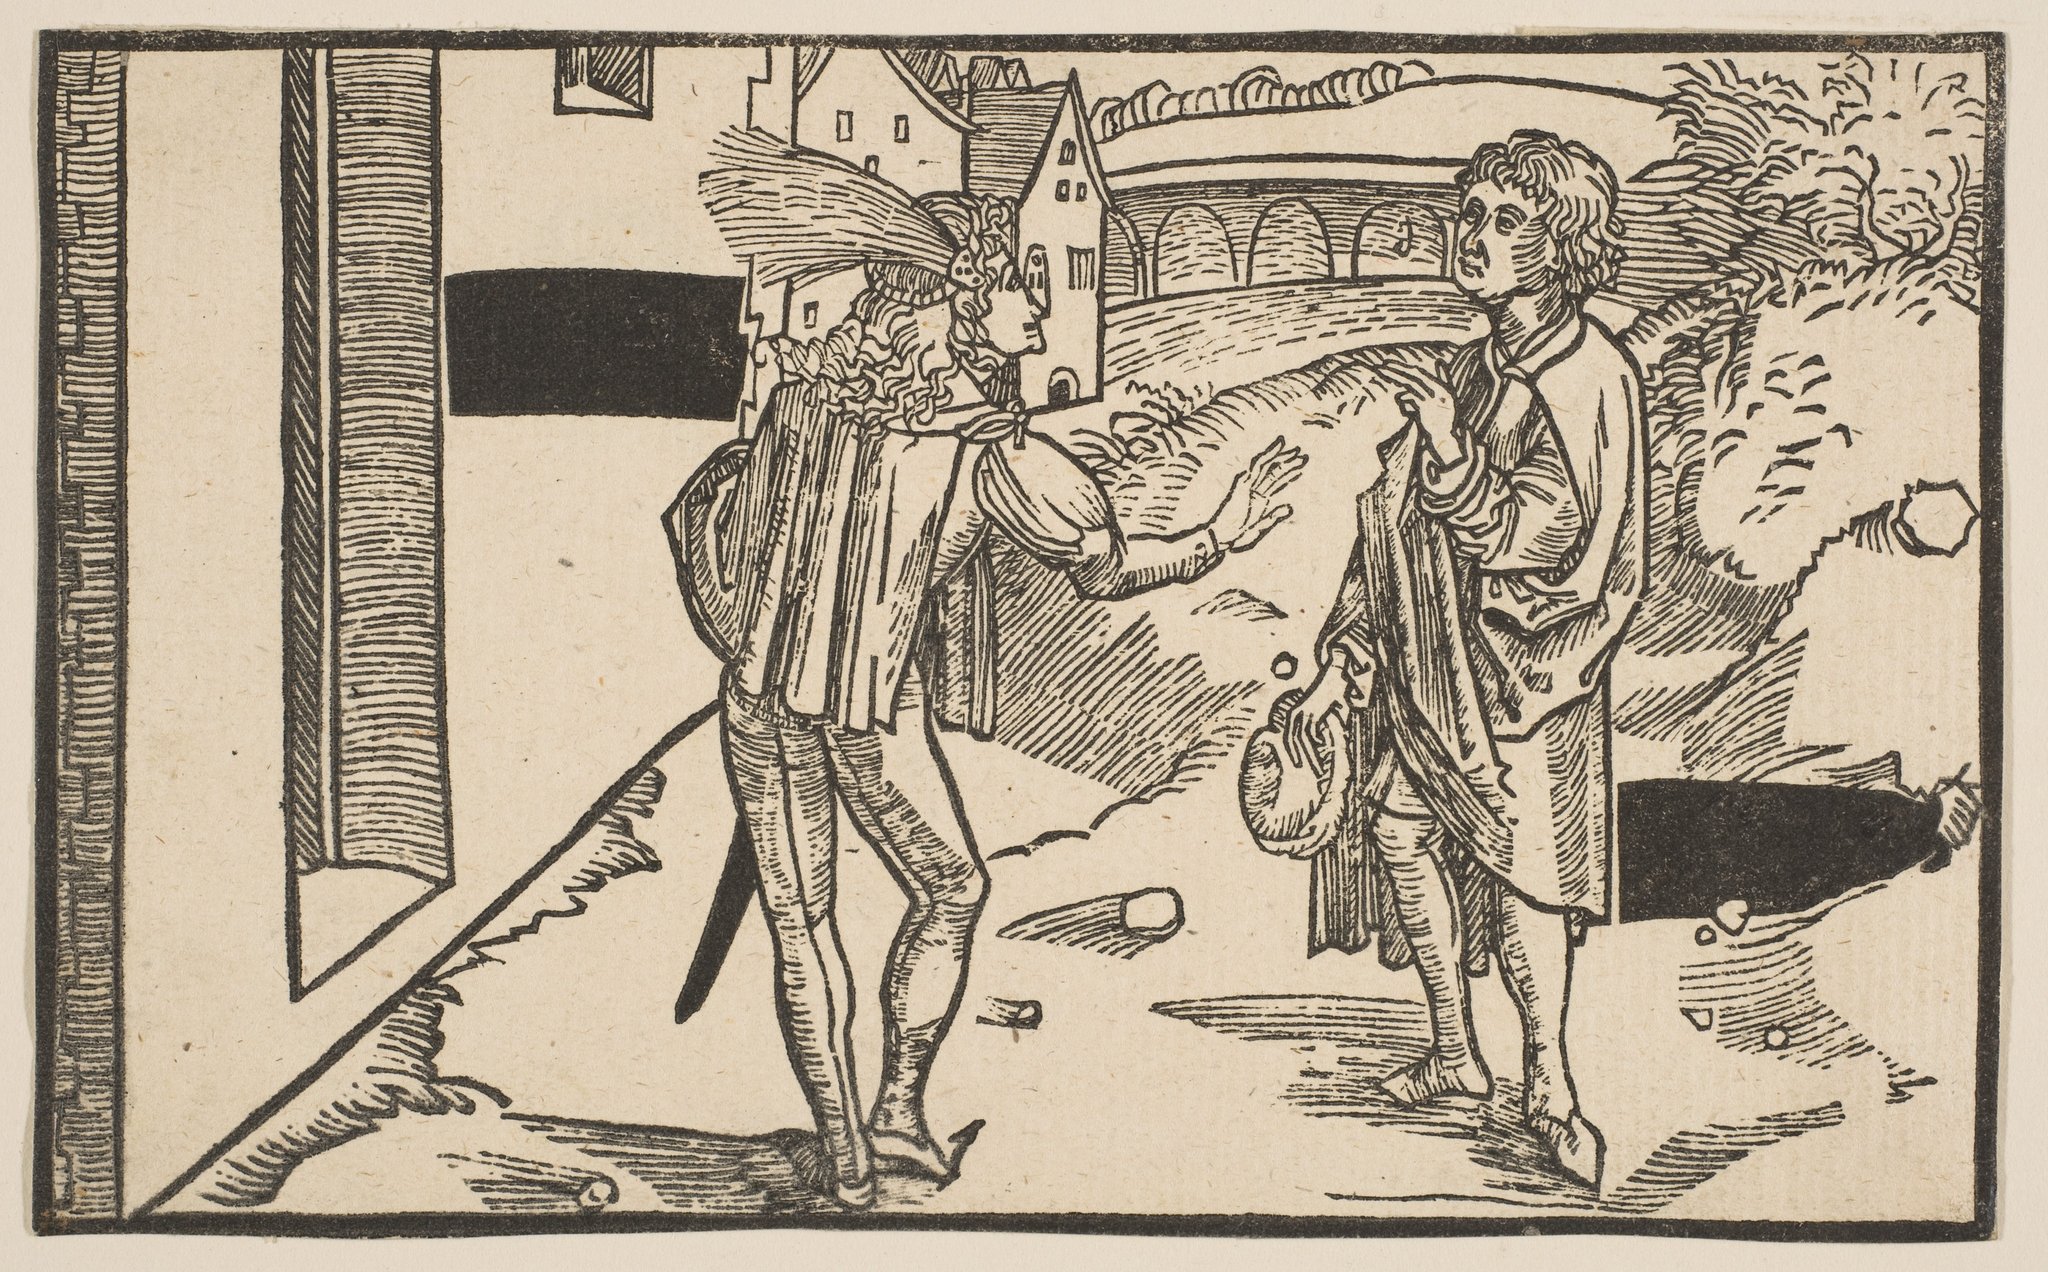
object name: print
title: Eunuchus, from "The Comedie of Terence", 19th century reprint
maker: albrecht dürer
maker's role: artist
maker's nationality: german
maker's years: 1471-1528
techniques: woodcut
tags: men